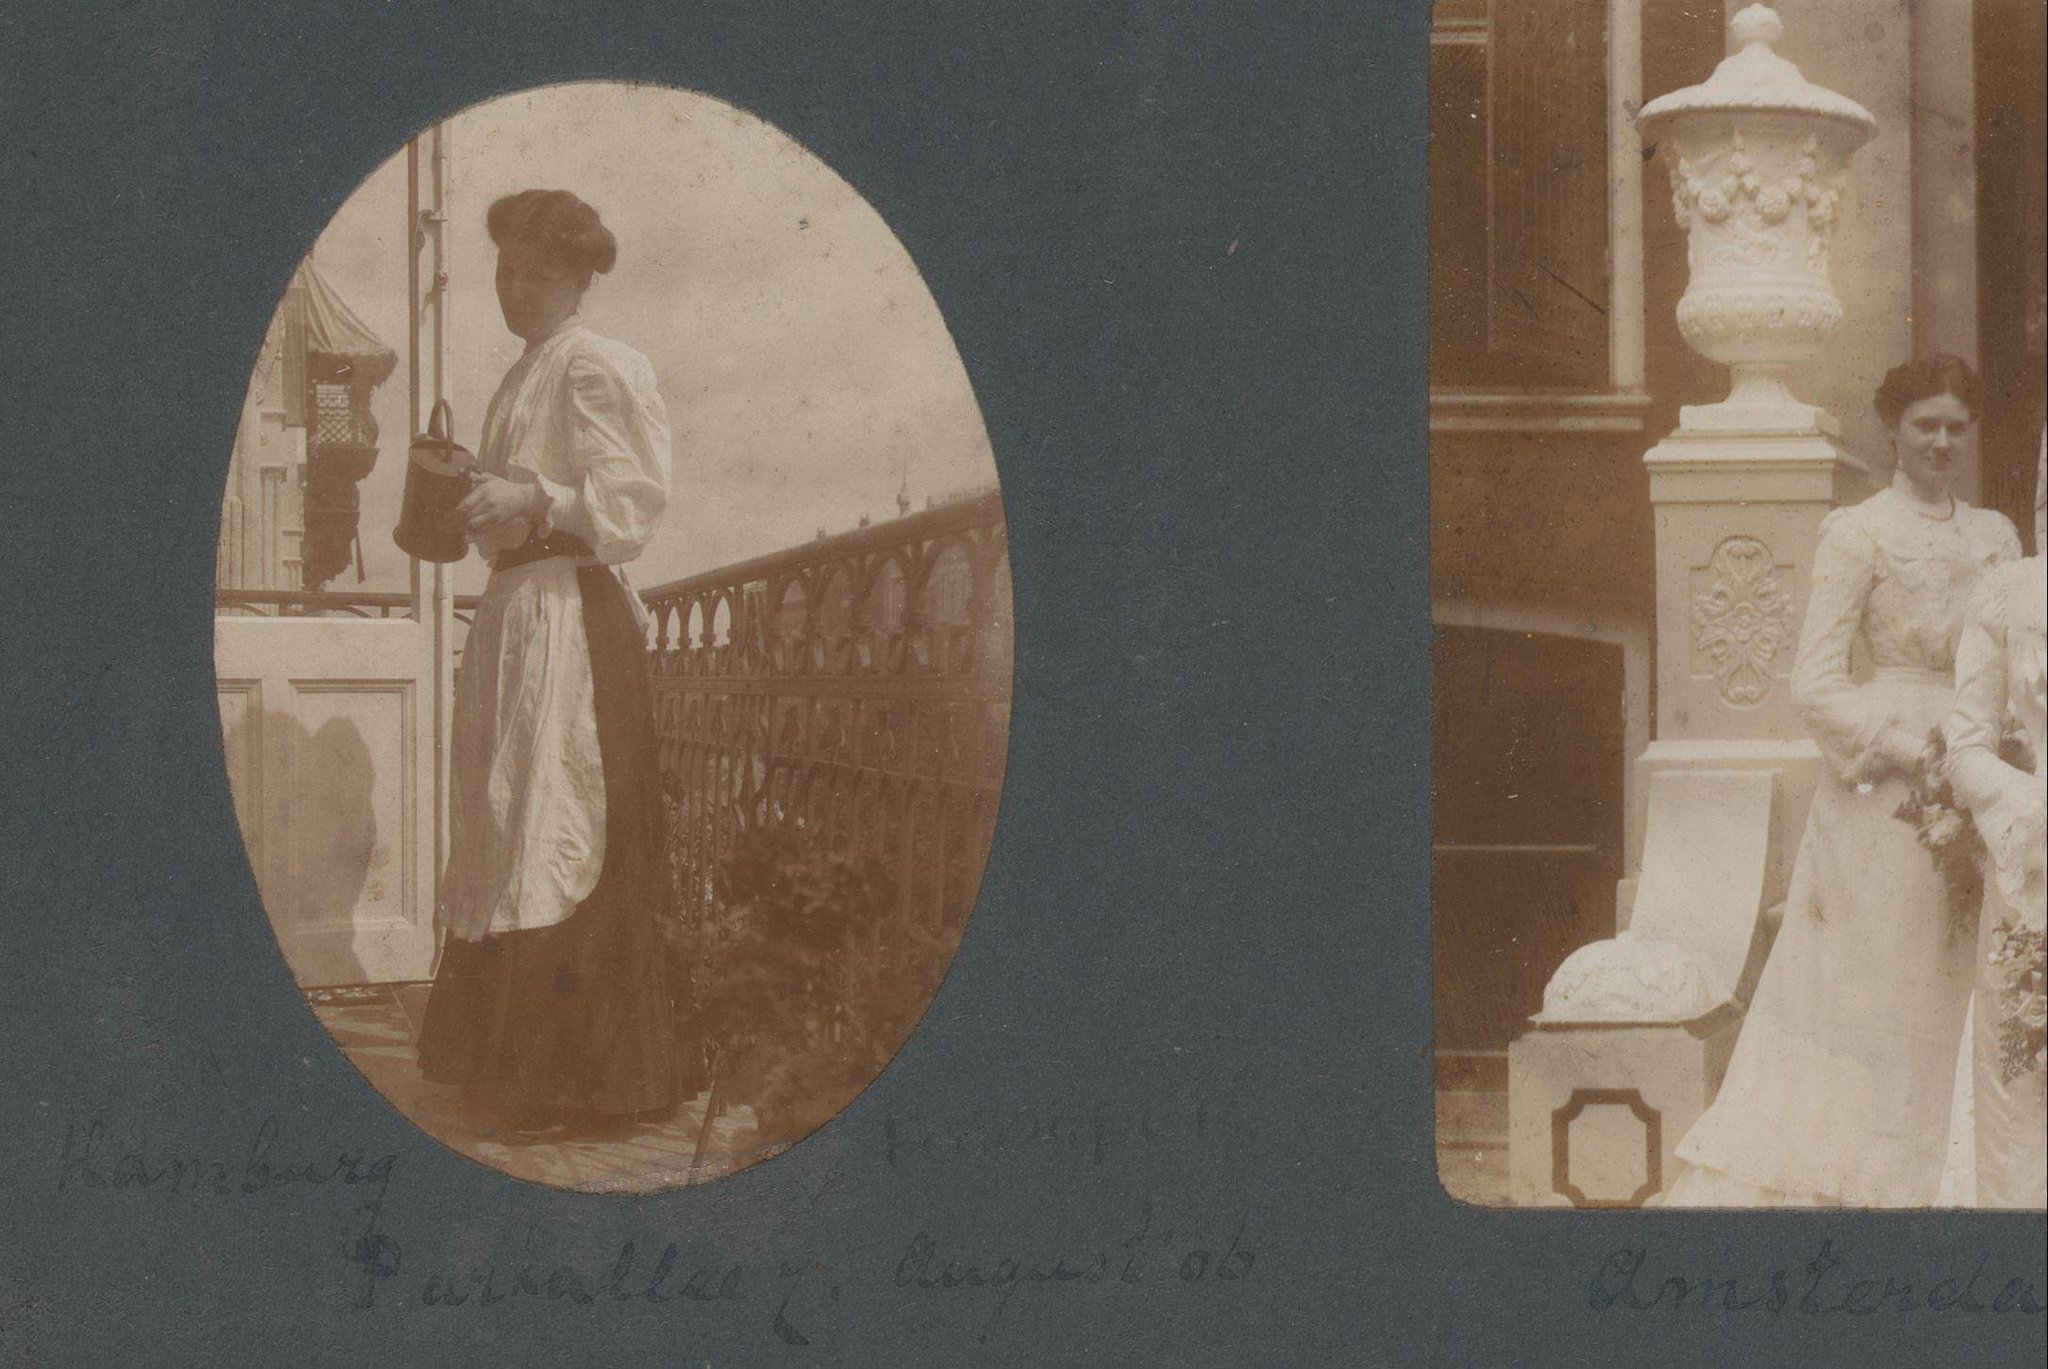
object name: album leaf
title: Portret van in vrouw met een gieter in de hand op een balkon in Hamburg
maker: Anonymous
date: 1906-1908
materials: cardboard, paper, photographic support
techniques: collodion silver print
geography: hamburg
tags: adult woman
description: Onderdeel van Reisalbum van een Nederlandse familie met bezienswaardigheden in Europa, Egypte en New York.